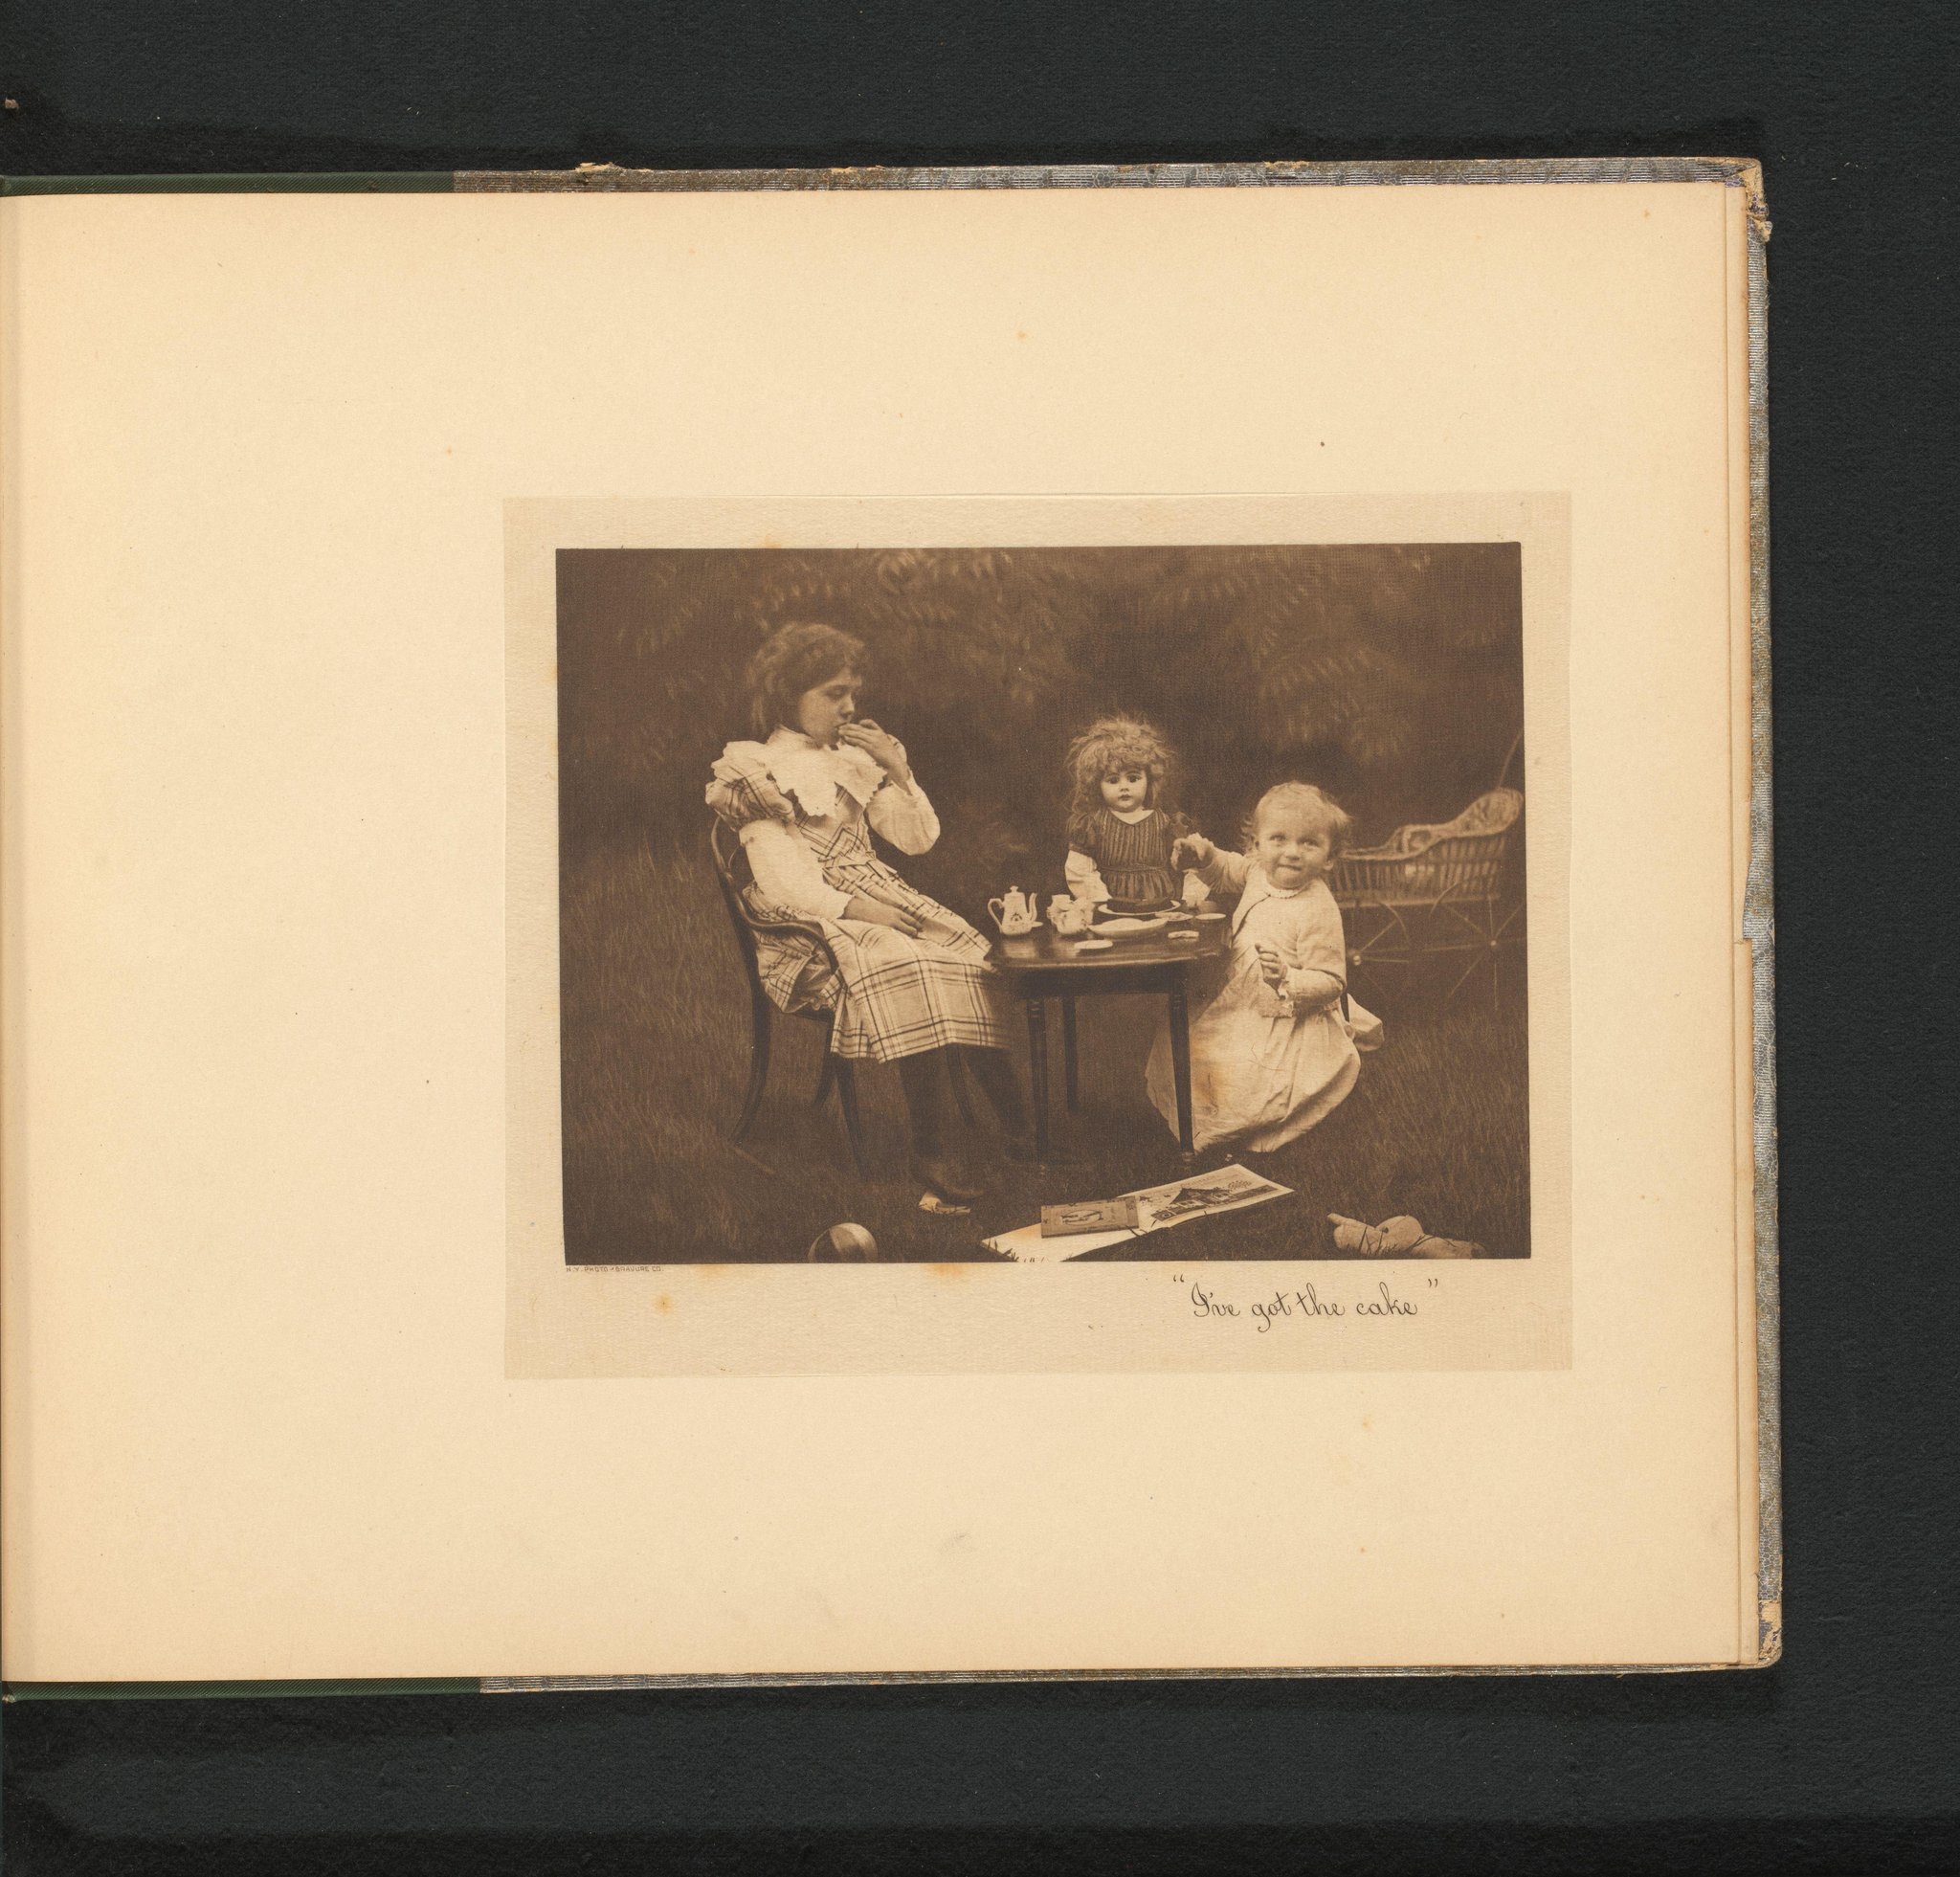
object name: page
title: “I've got the cake”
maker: walter george mitchell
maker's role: fotograaf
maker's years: 1877-1935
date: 1881-1891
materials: paper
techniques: photoaquatint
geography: new york city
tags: afternoon tea - cc - out of doors, girl (child between toddler and youth), (playing with) dolls